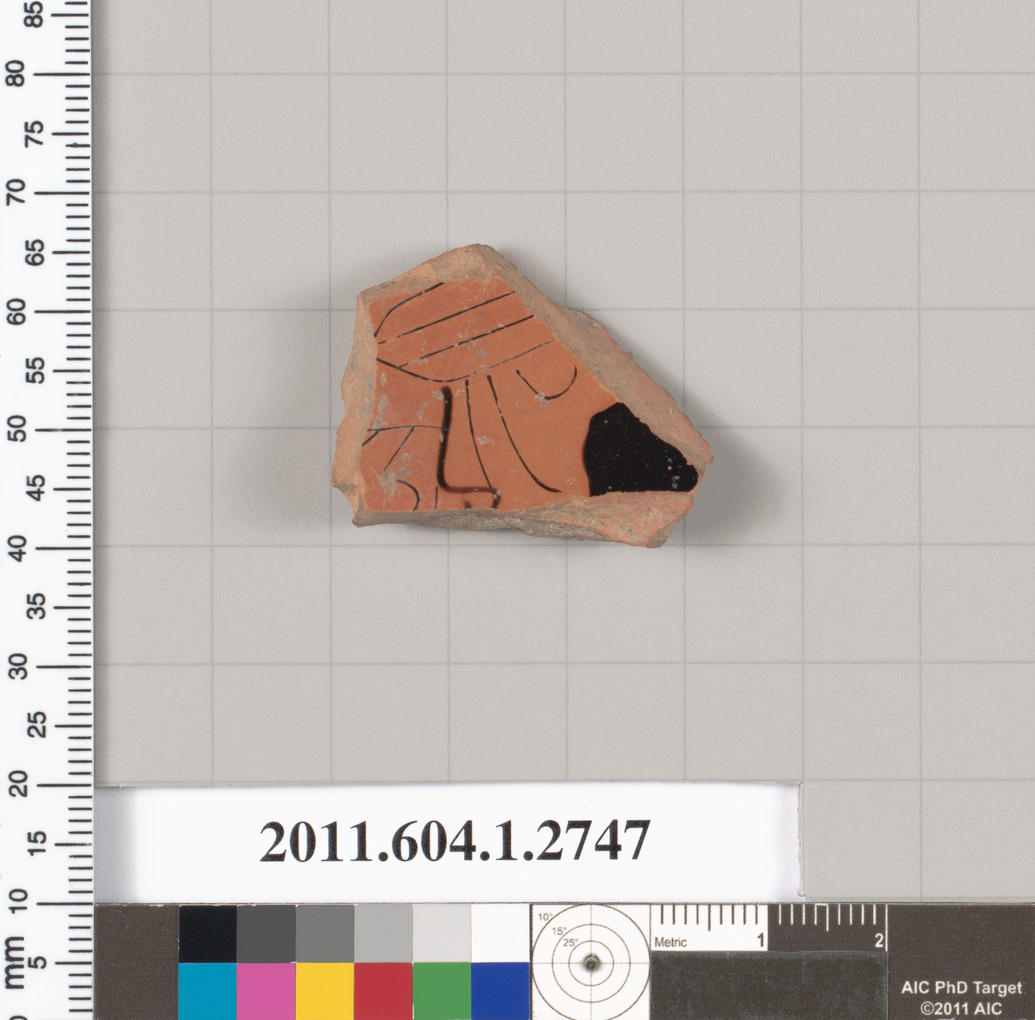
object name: kylix fragment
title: Terracotta fragment of a kylix (drinking cup)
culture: greek, attic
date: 467-435 BCE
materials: terracotta